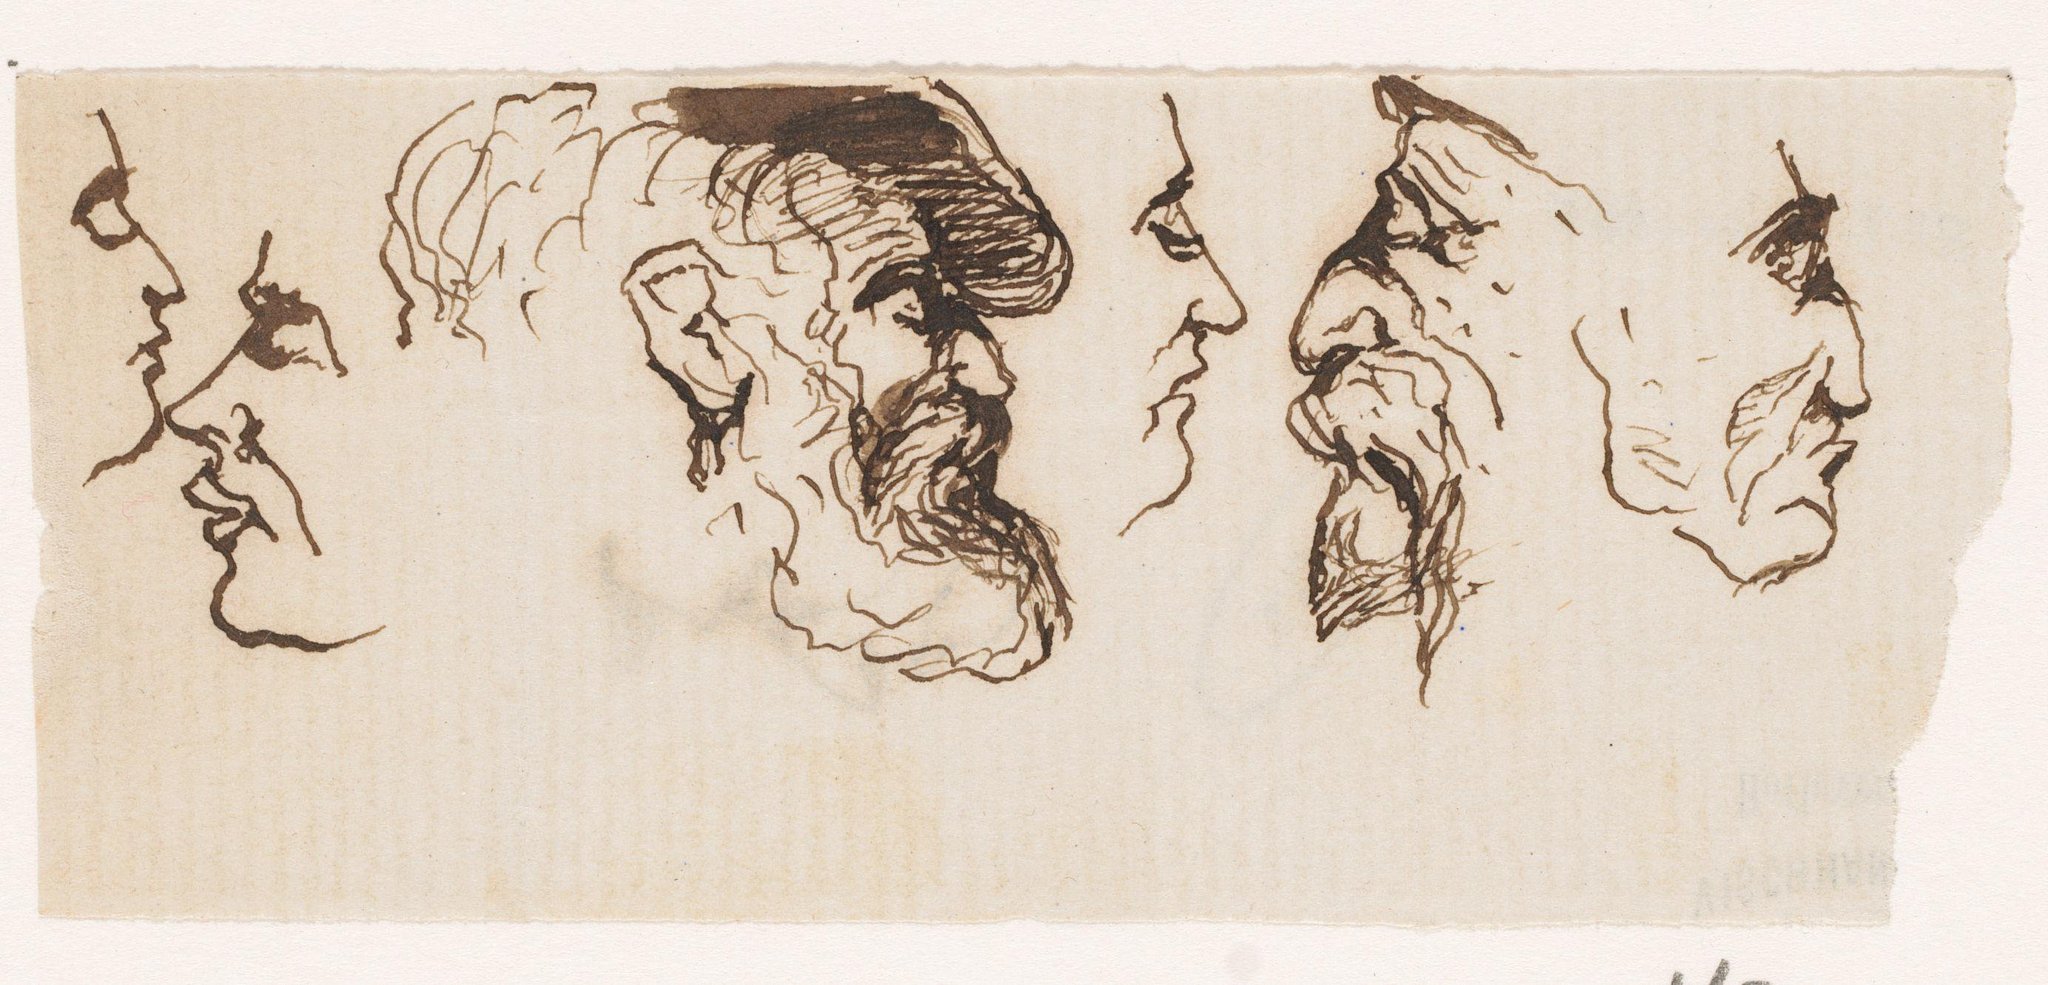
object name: drawing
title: Rijtje koppen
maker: johannes tavenraat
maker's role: draughtsman, painter, print maker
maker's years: 1809-1881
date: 1840-1880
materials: ink, paper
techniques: pen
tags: caricatures (human types)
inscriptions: collector's mark: Lugt 2228